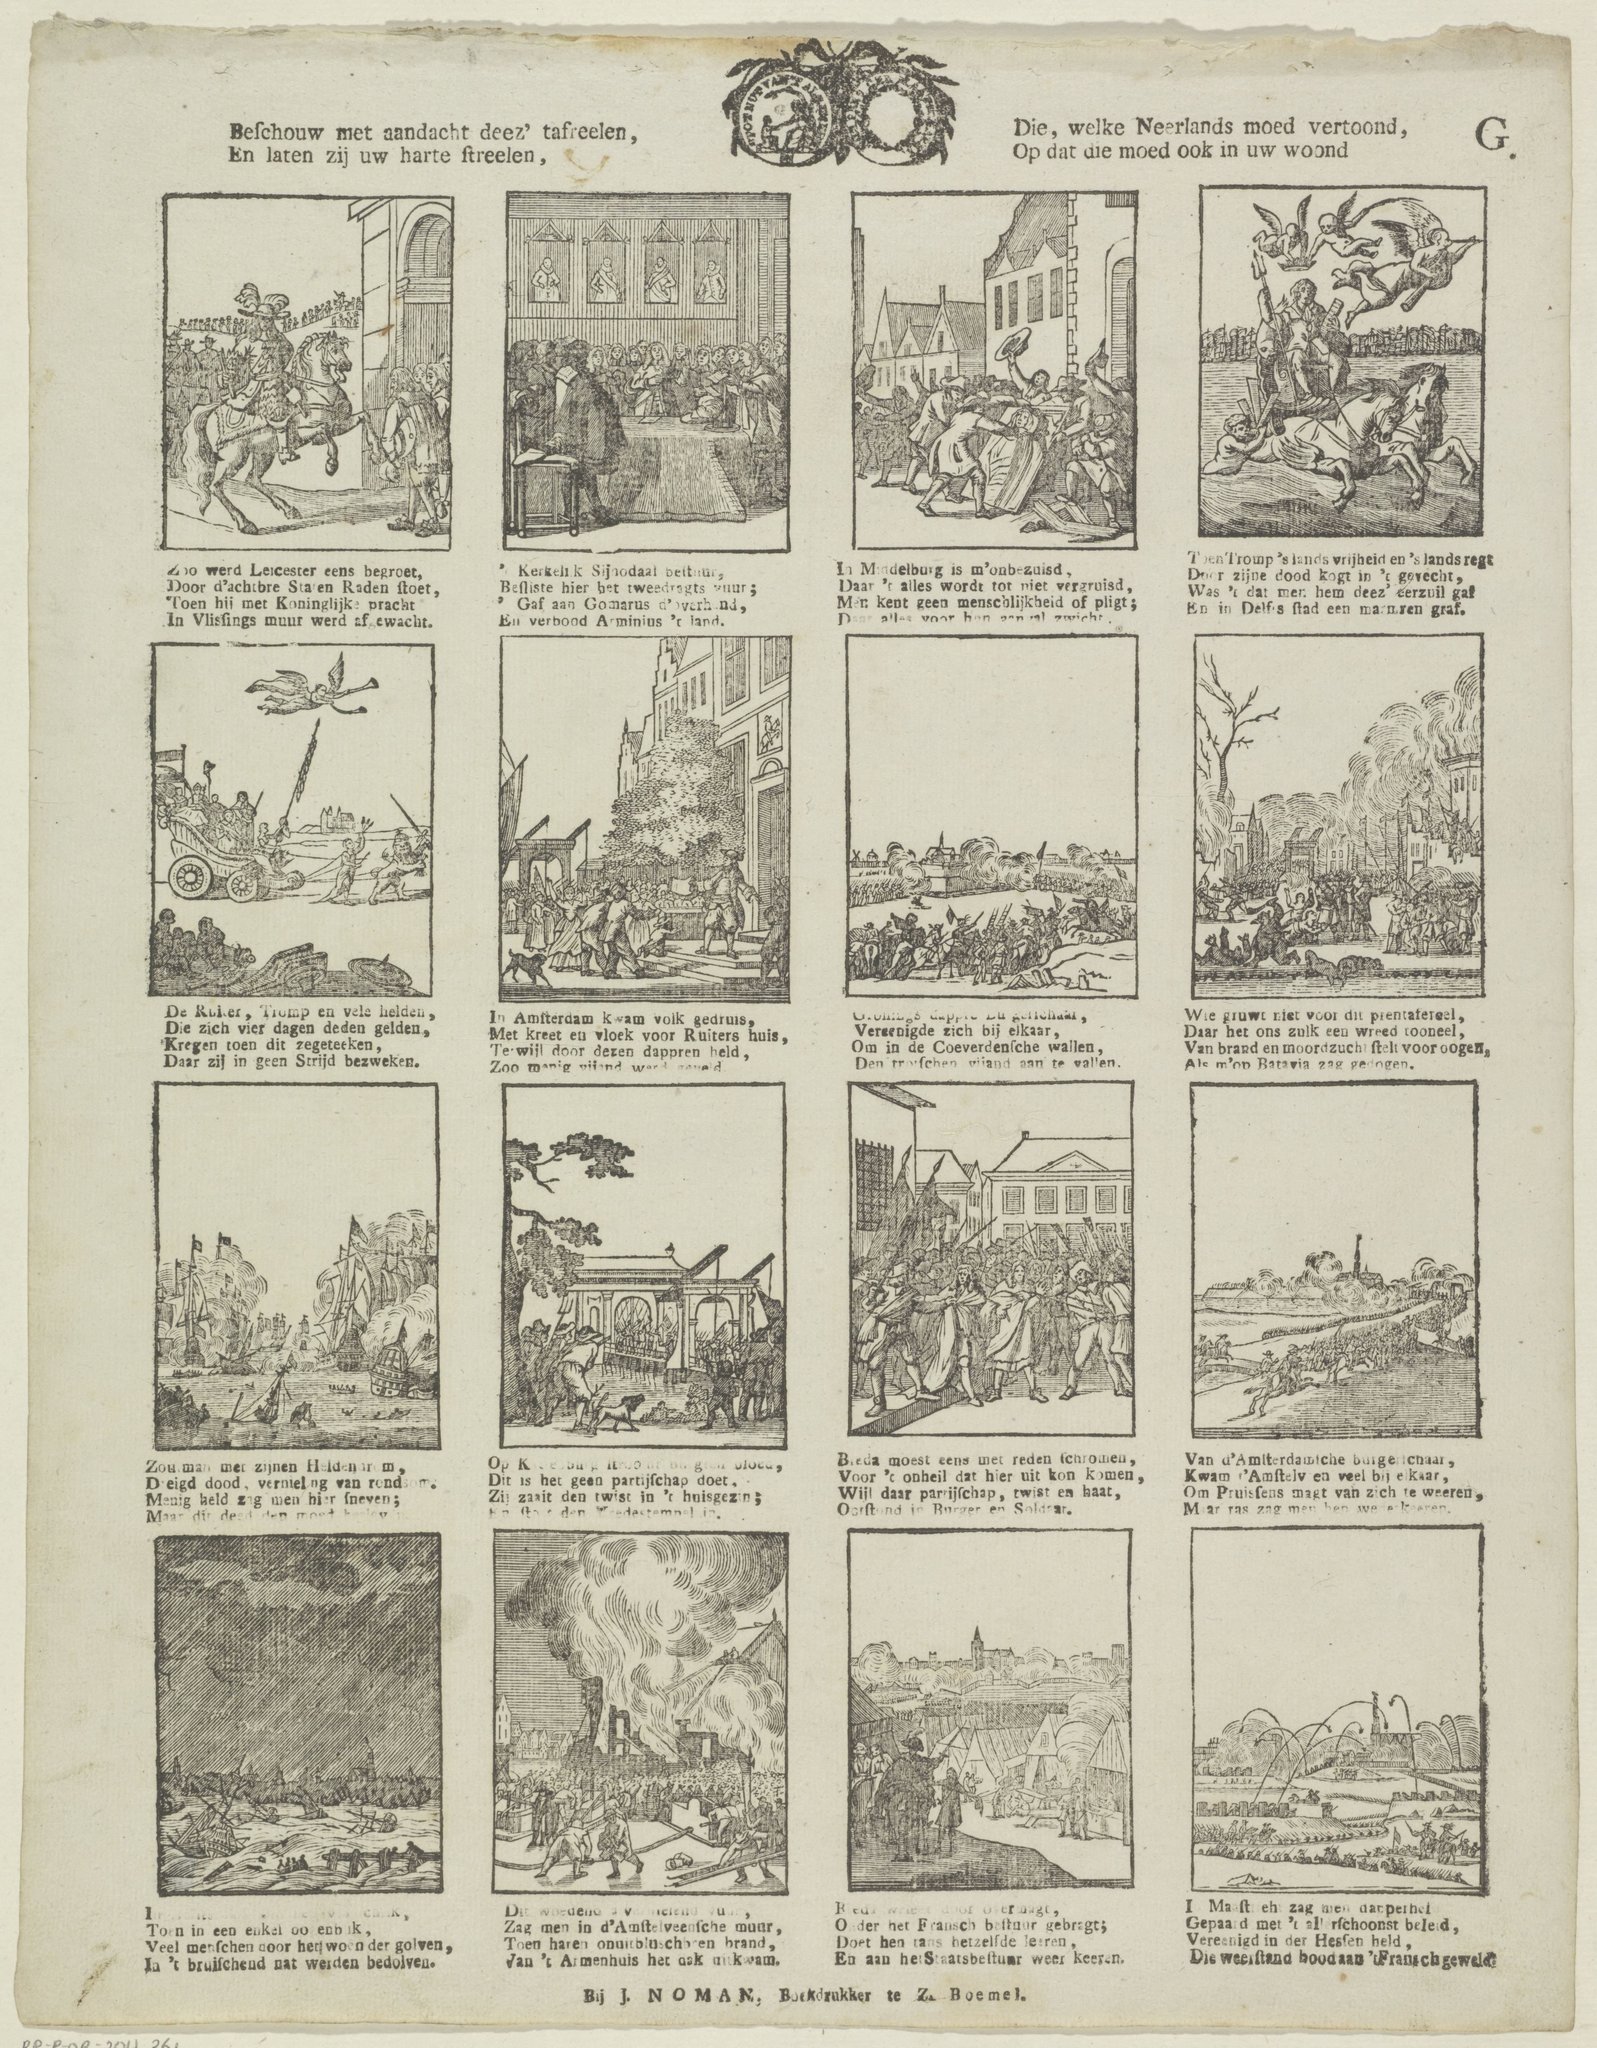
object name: print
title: Beschouw met aandacht deez' tafreelen, / En laten zij uw harte streelen, / Die, welke Neerlands moed vertoond, / Op dat die moed ook in uw woond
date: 1806-1830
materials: paper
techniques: letterpress printing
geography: zaltbommel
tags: flushing, michiel adriaenszoon de ruyter, rotterdam, cornelis tromp, leiden, bruges, robert dudley (1st earl of leicester), history, delft, middelburg, amsterdam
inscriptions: collector's mark: Lugt 2760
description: Blad met 16 voorstellingen van gebeurtenissen uit de vaderlandse geschiedenis, zoals het ontzet van Coevorden in 1594 en het ontzet en de inname van Breda in 1637. Onder elke afbeelding een vierregelig vers. Midden boven het zegel van de Maatschappij tot Nut van 't Algemeen. Gemerkt rechtsboven: G.